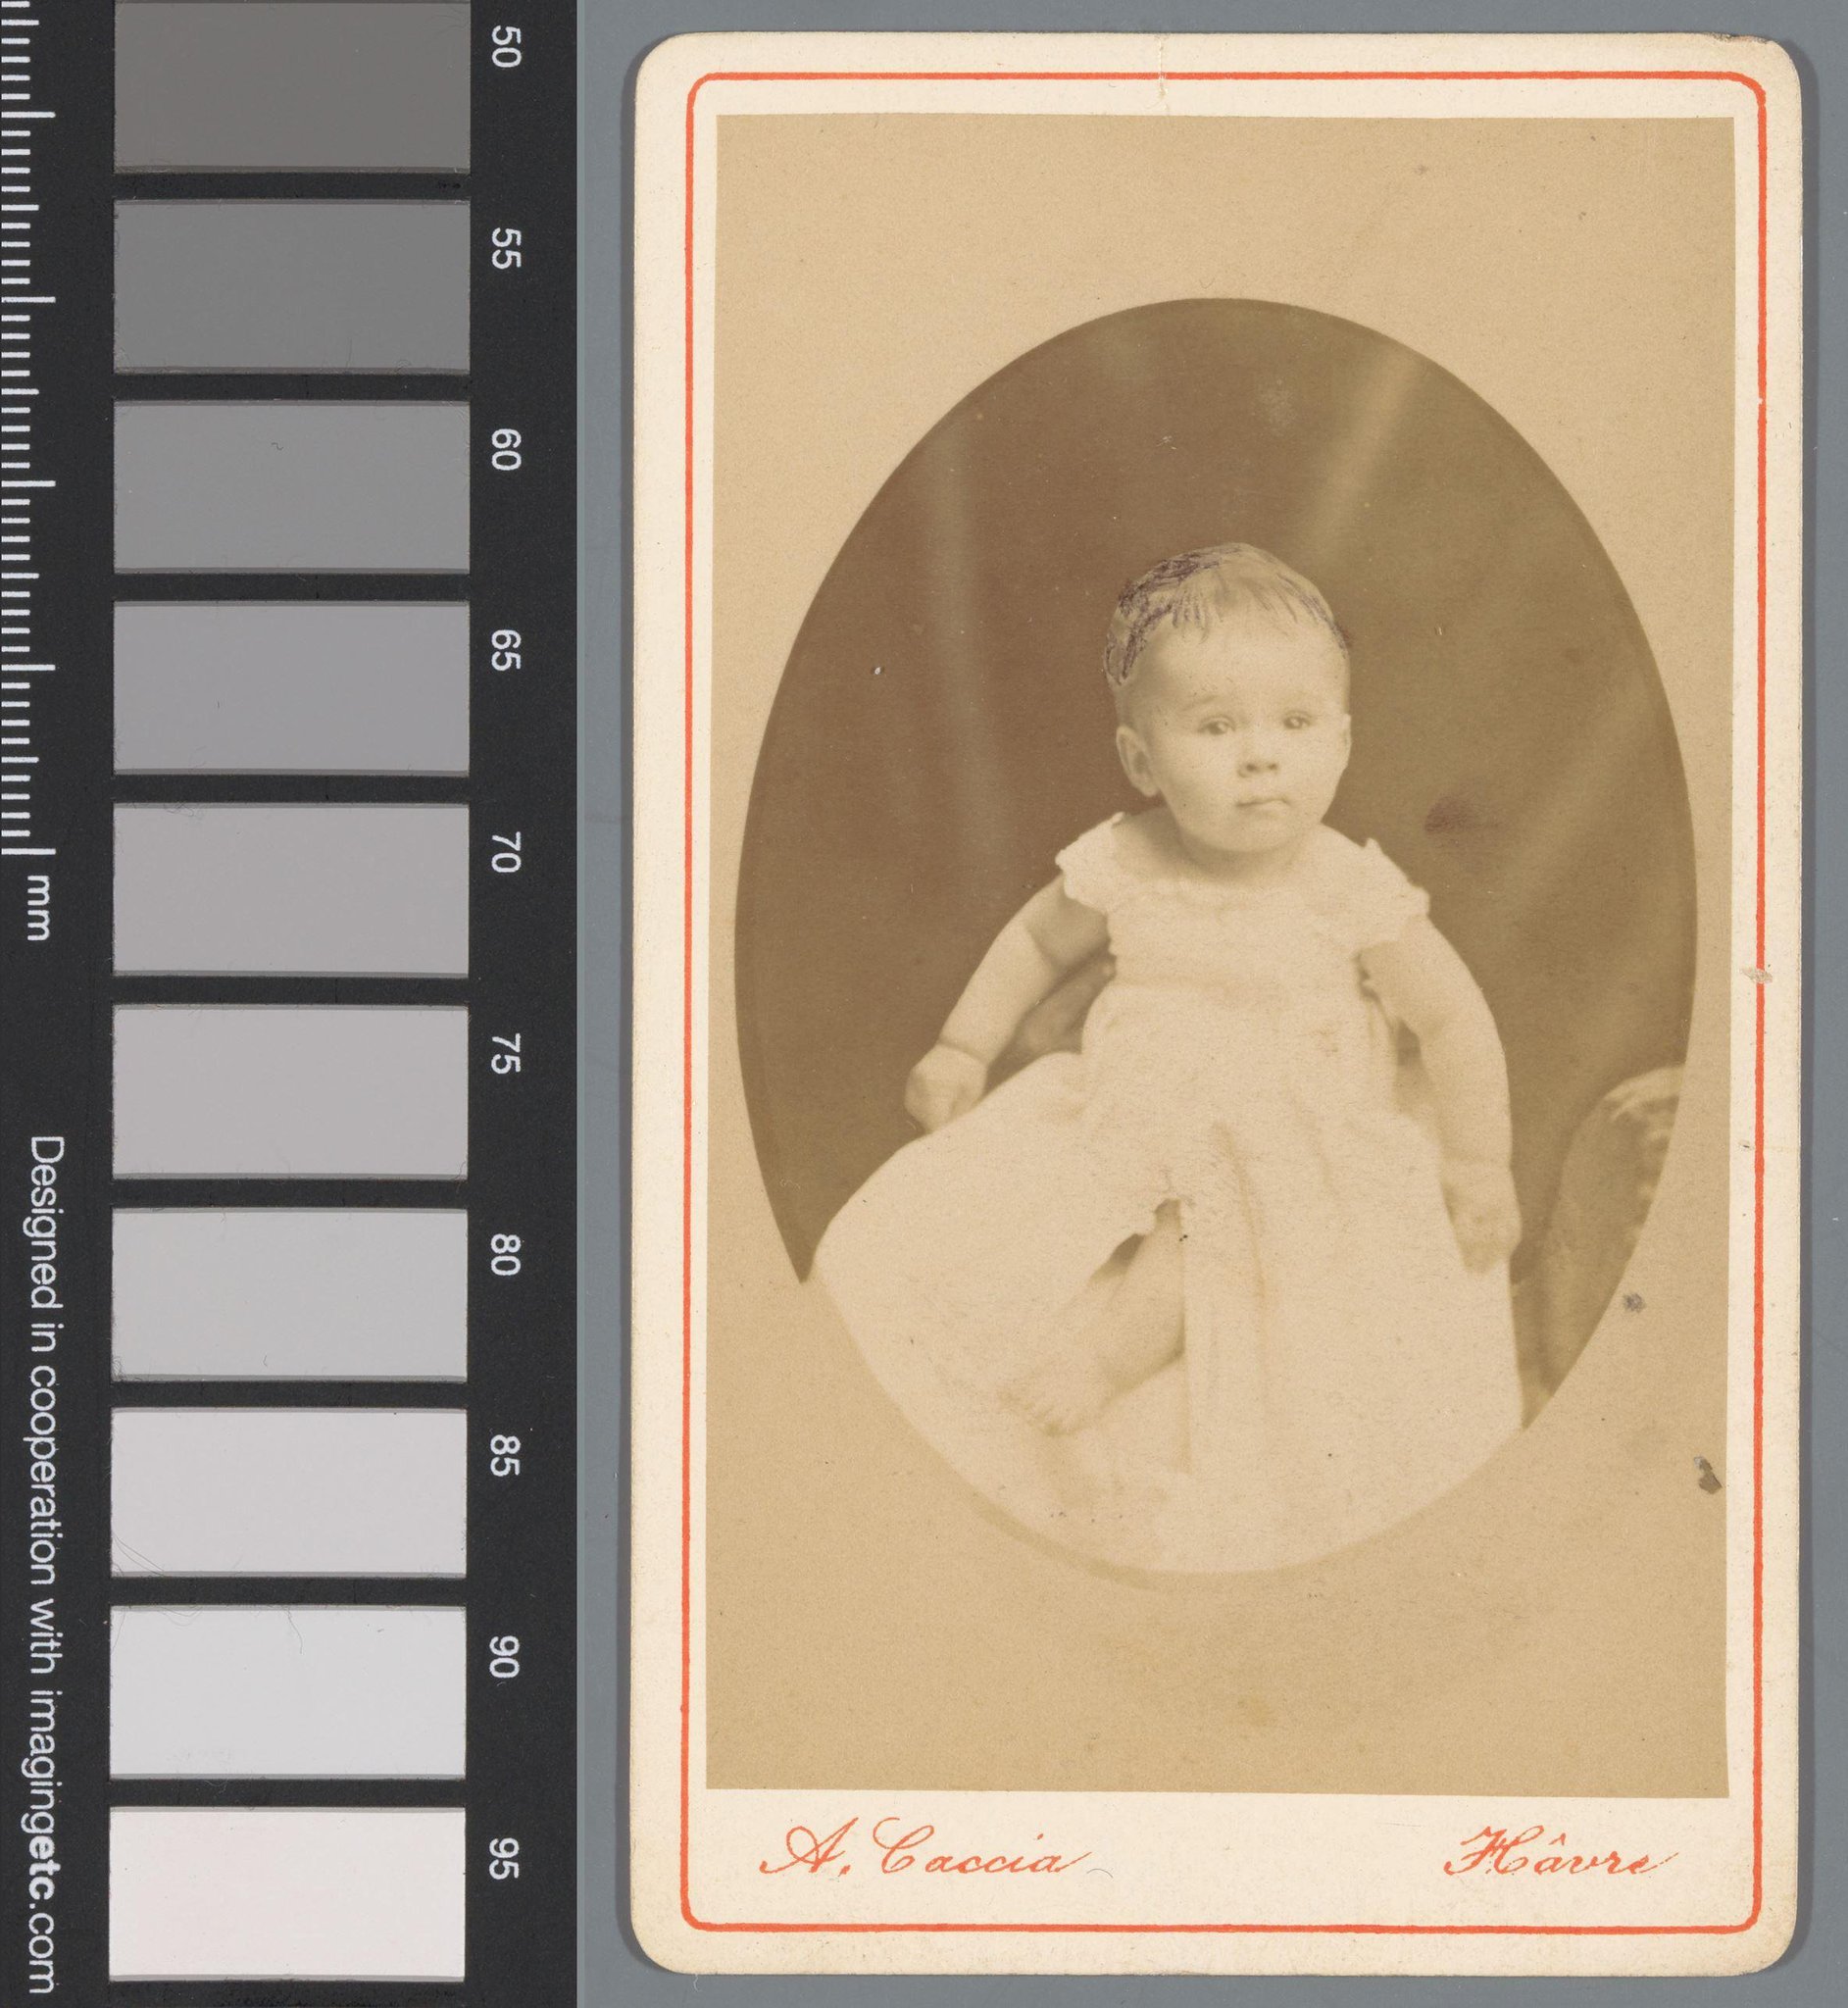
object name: carte de visite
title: Portret van een onbekende baby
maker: angelo maria alessio caccia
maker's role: fotograaf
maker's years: 1802-1877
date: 1868-1890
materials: cardboard, ink, paper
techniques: albumen print, pen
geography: le havre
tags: anonymous historical person portrayed, infant, baby ~ the ages of man, le havre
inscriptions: inscription: ‘A. Caccia/ 126/ Boulevard de Strasbourg/ Hâvre.’, inscription: ‘A. Caccia Hâvre’